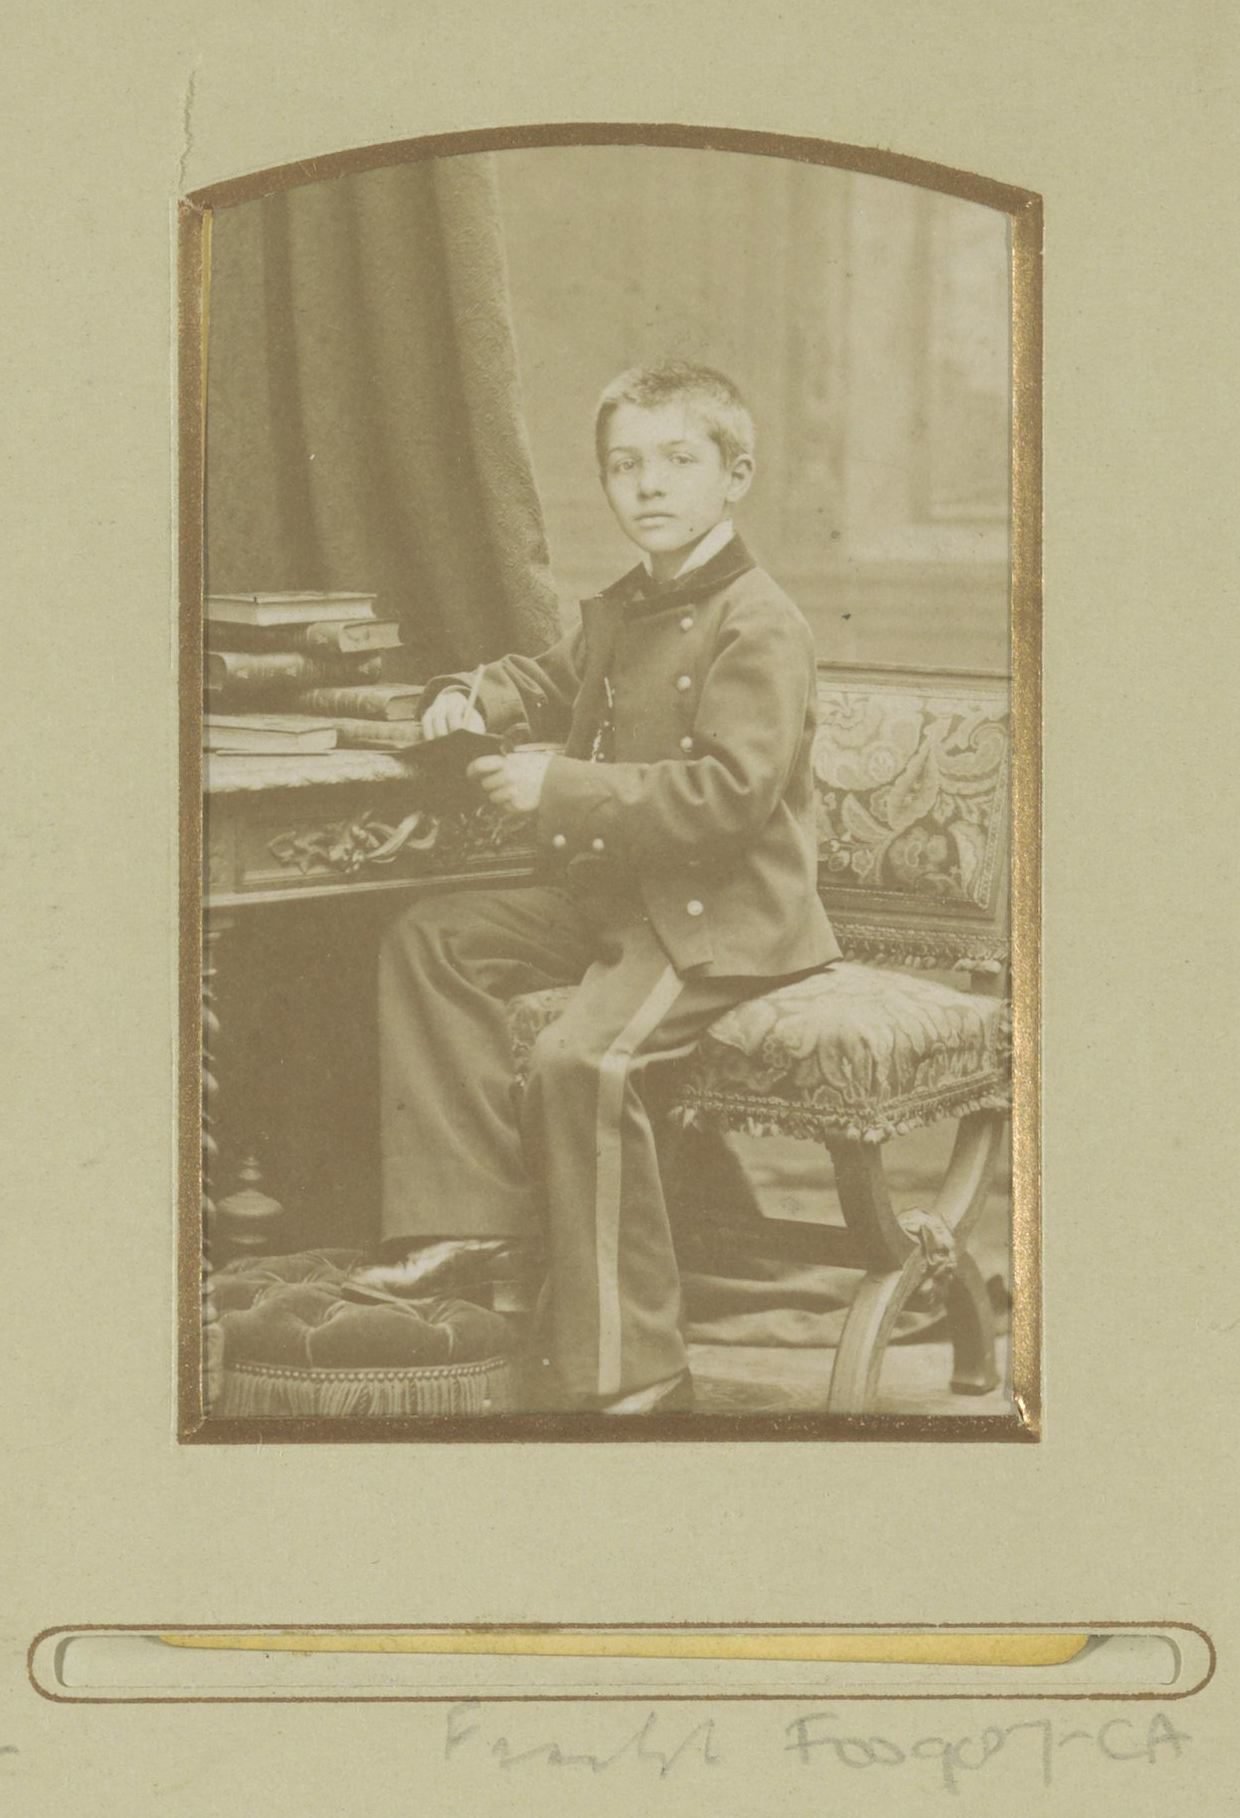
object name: photograph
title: Portret van een jongen, zittend in een uniform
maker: françois chéri rousseau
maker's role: fotograaf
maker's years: 1826-1908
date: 1878-1900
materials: cardboard, paper, photographic support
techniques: albumen print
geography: france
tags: handwriting, writing as activity, studio requisites ~ photographer, child, warfare; military affairs, (military) uniforms, division of armed forces, france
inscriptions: address: ‘8 Place de l'Hôtel de Ville, St. Étienne / 14 Boulevard du Musée Marseille’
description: Onderdeel van Album met cartes-de-visite en kabinetfoto's van militairen in uniform.